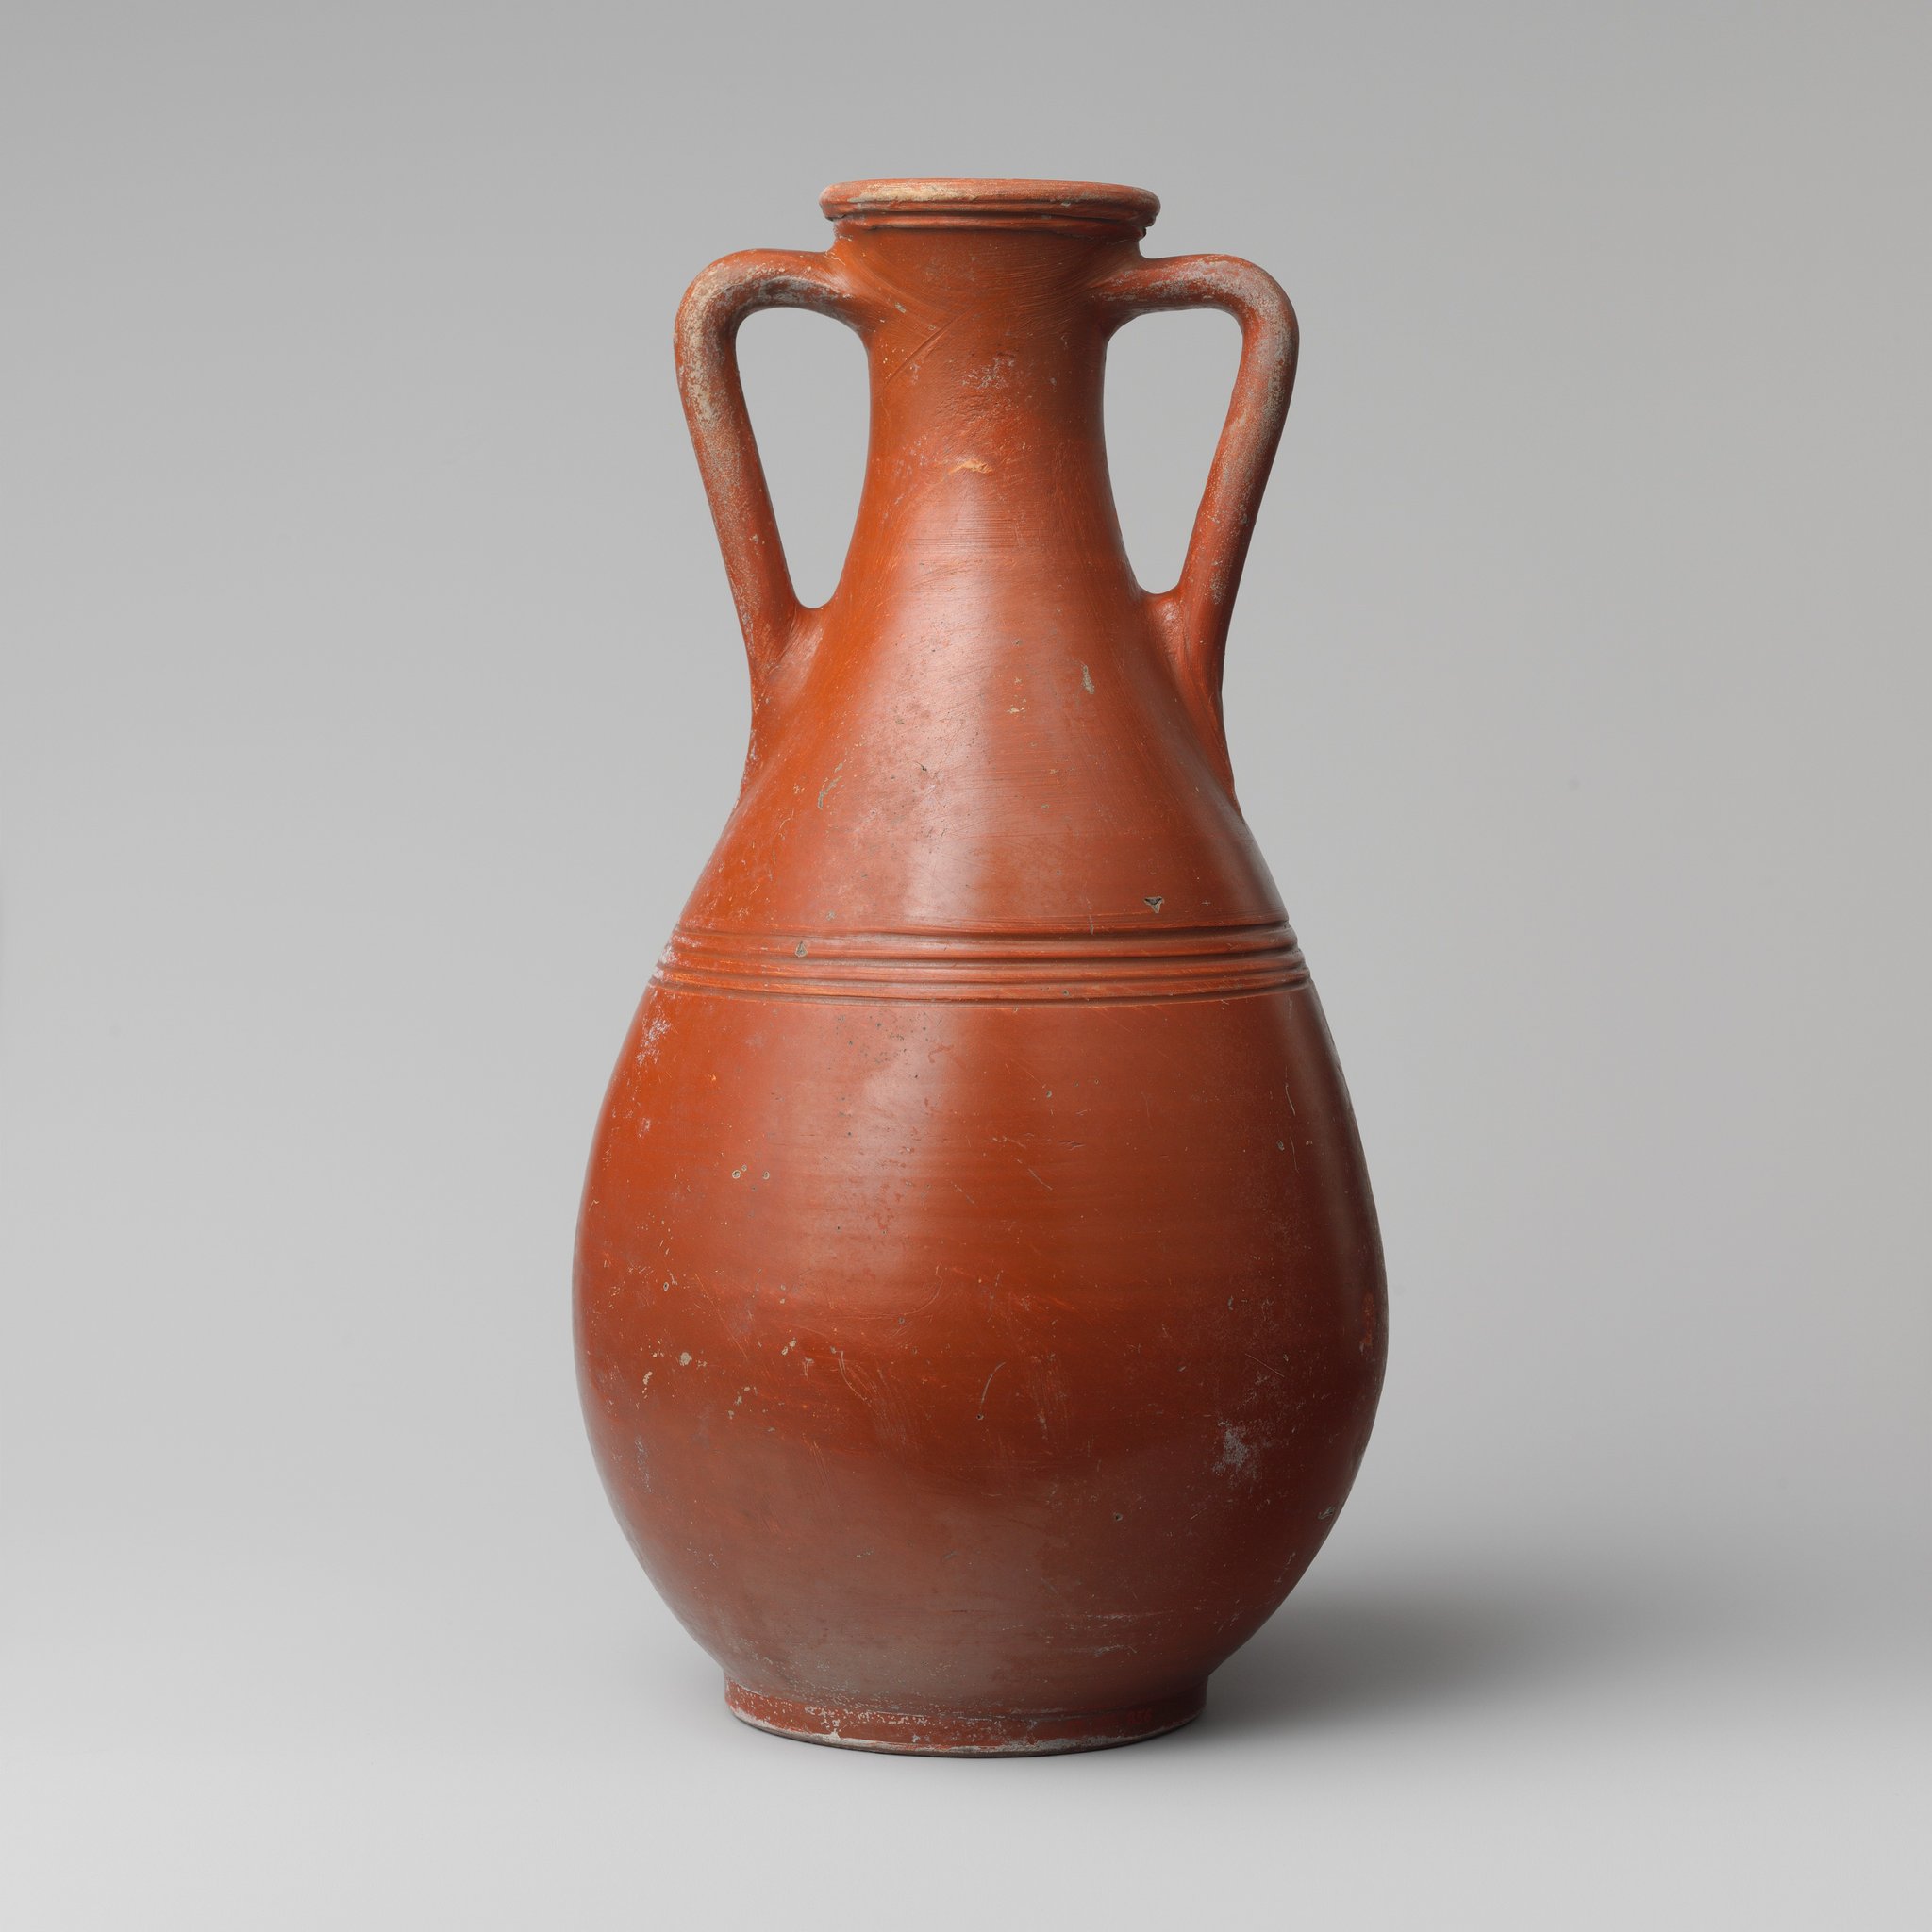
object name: amphora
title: Terracotta amphora (jar)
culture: roman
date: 51-100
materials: terracotta